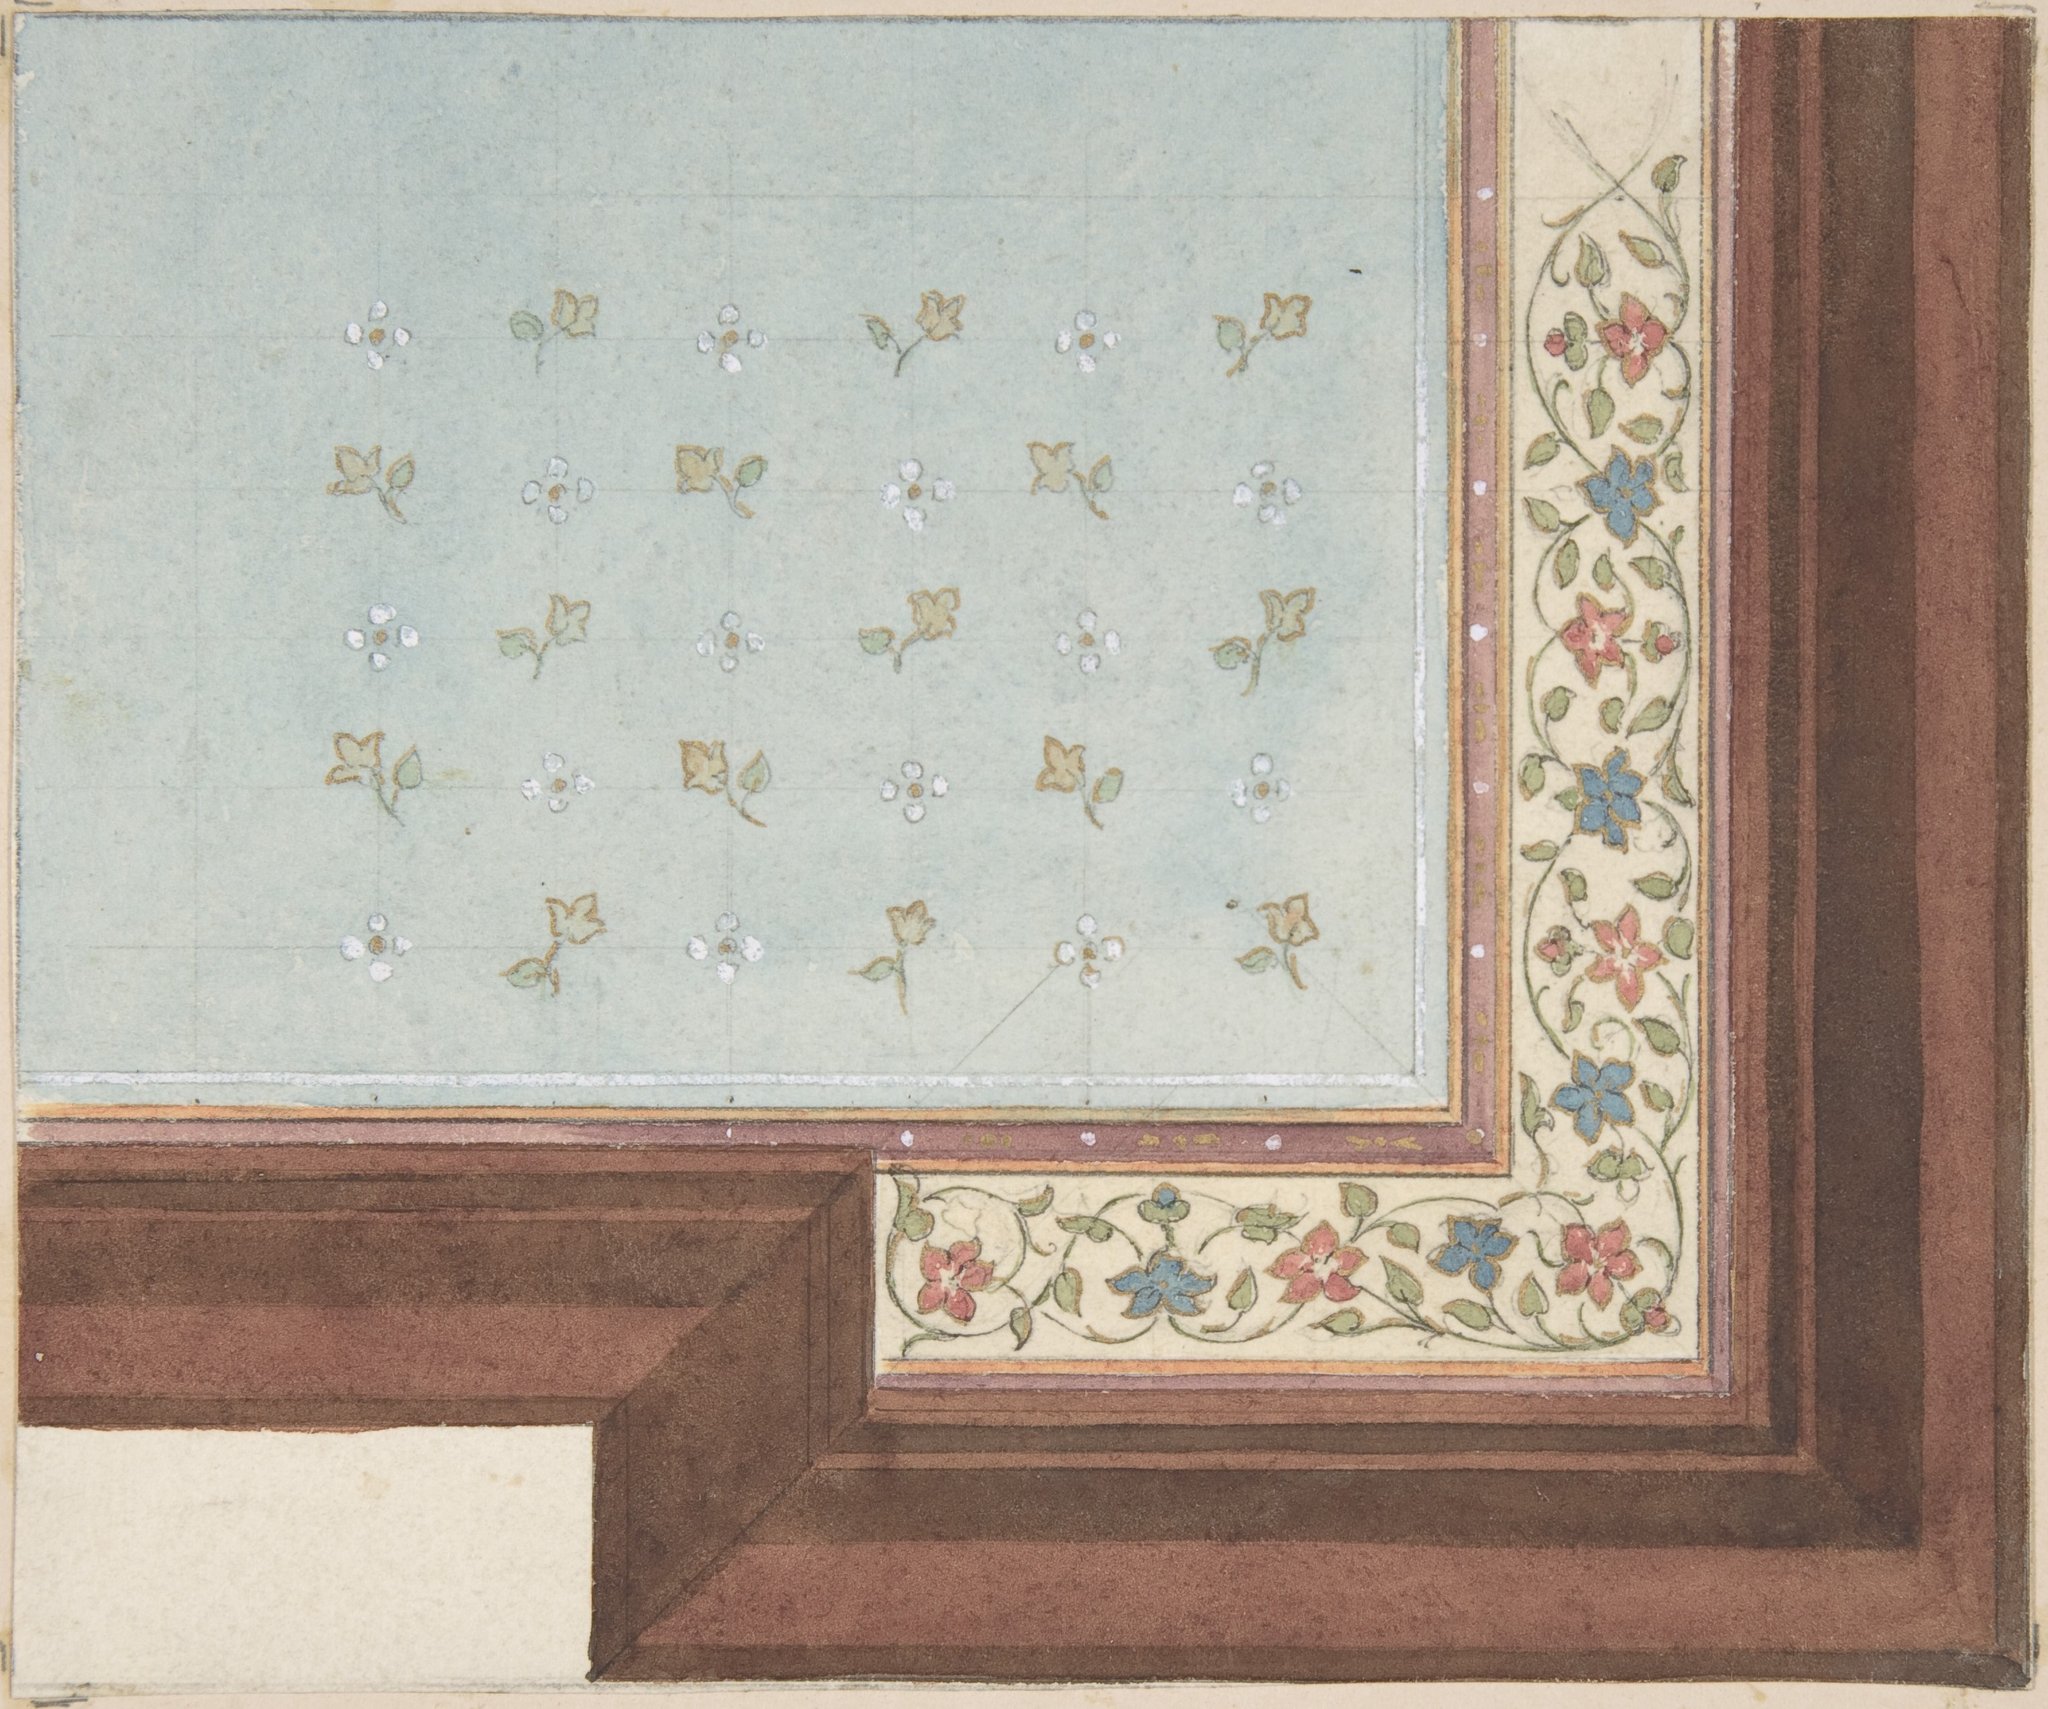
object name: drawing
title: Design for Ceiling, Hôtel Hope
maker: jules-edmond-charles lachaise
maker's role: artist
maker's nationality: french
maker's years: 1897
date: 1867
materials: gouache, watercolor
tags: flowers,ceilings